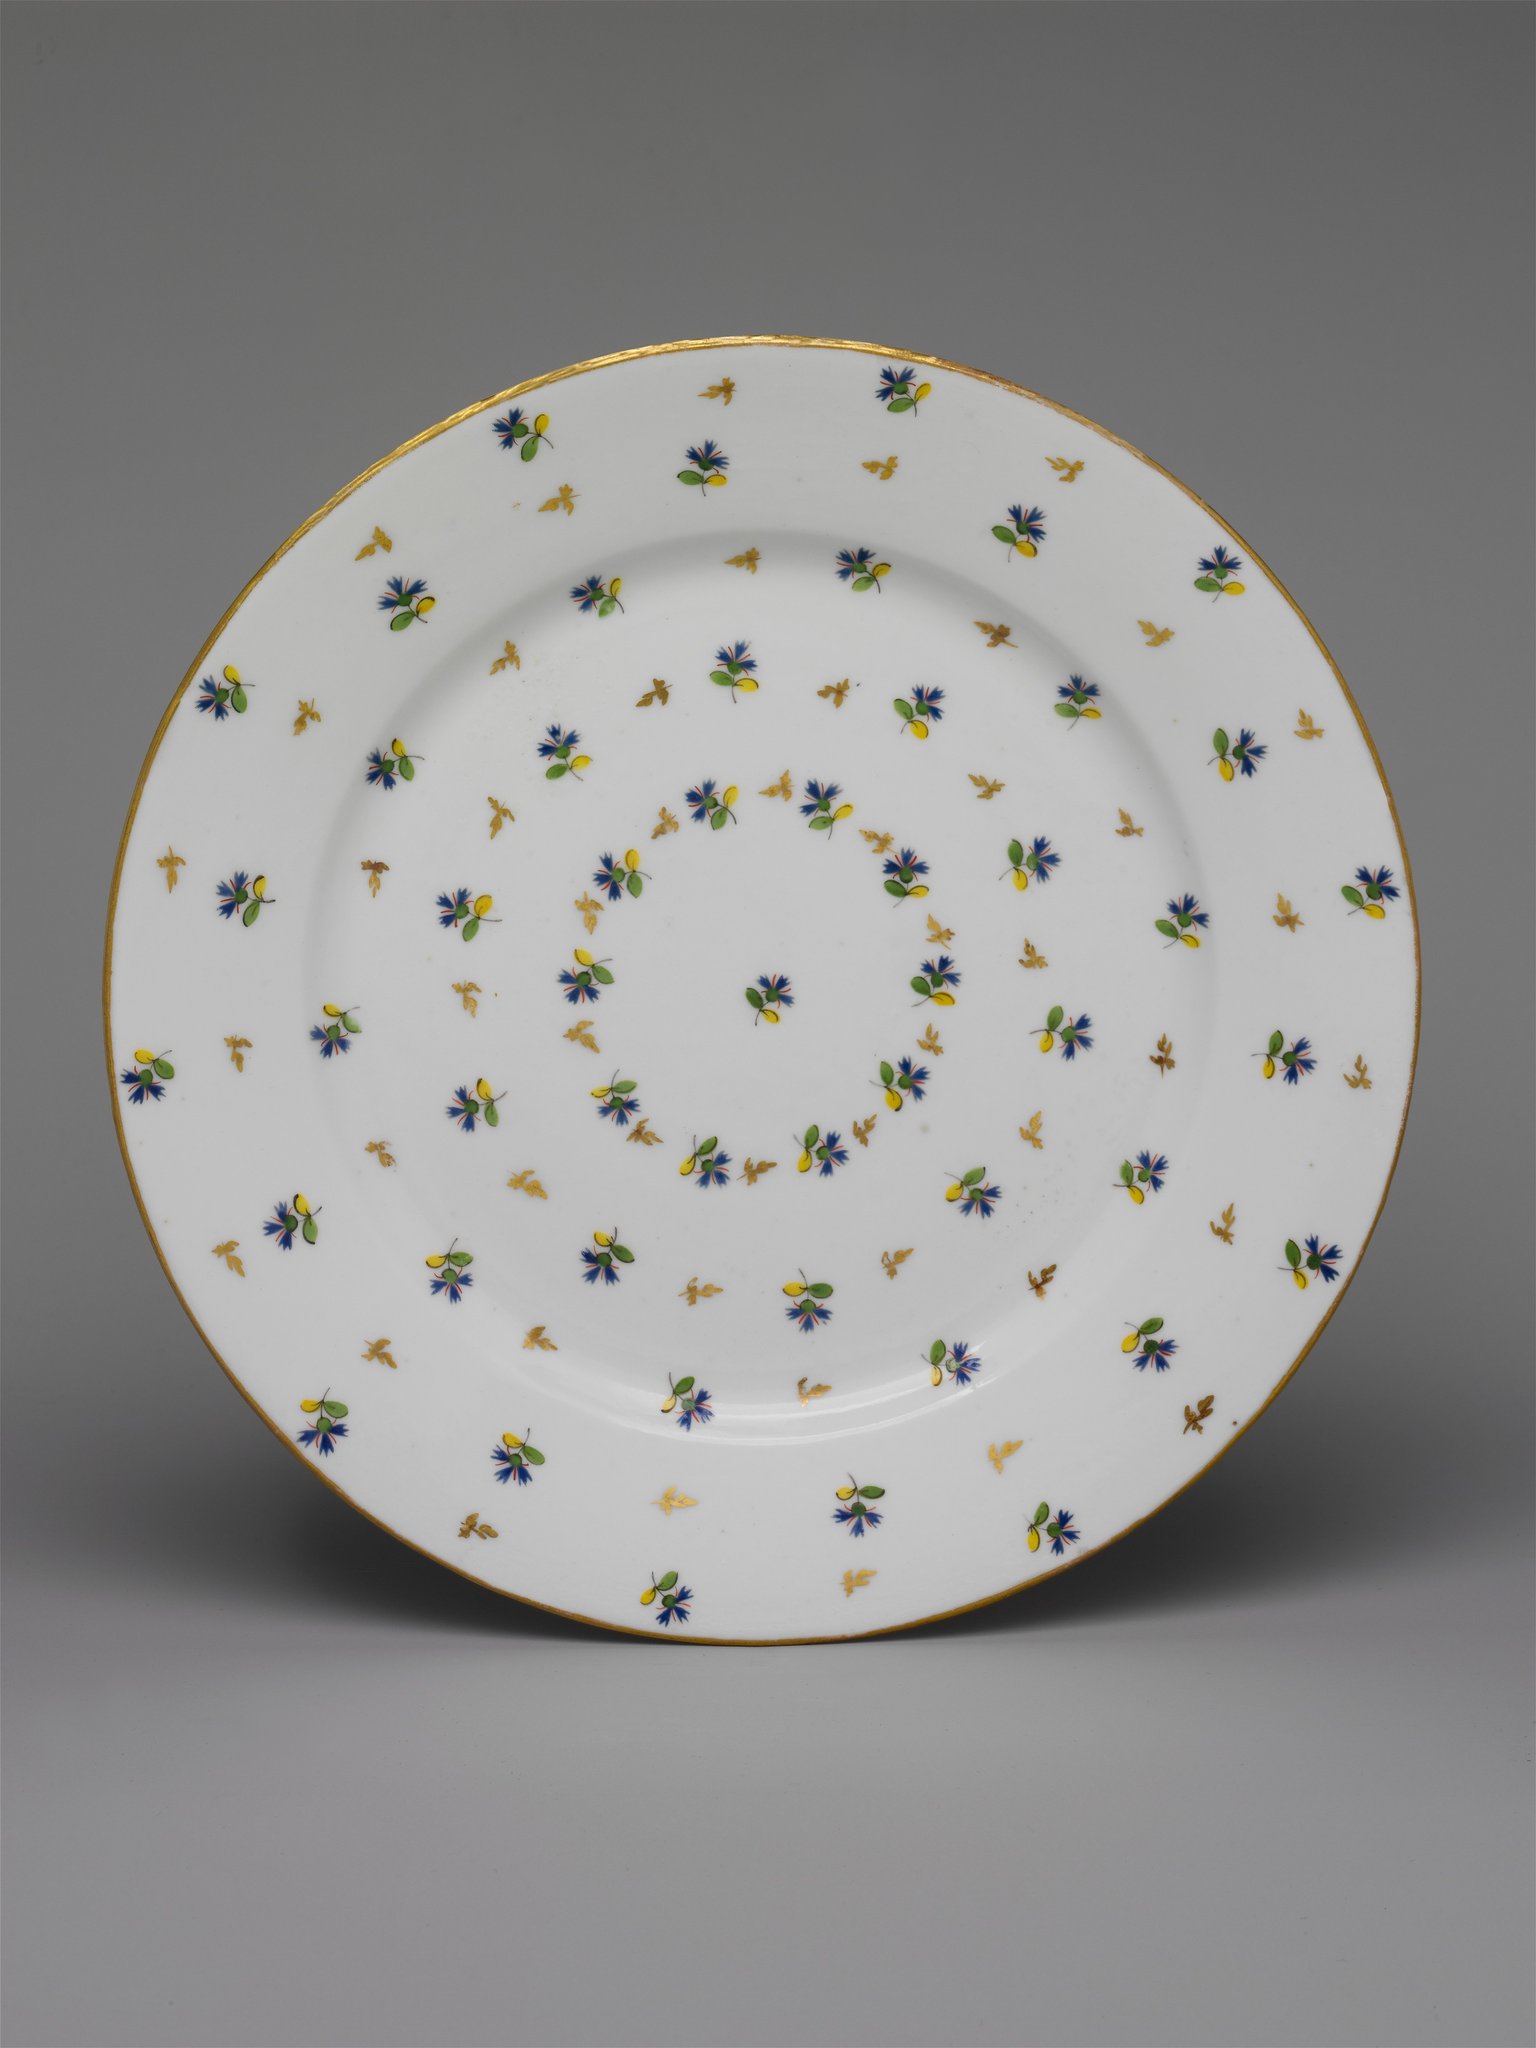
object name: cake plate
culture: french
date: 1780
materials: porcelain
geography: france